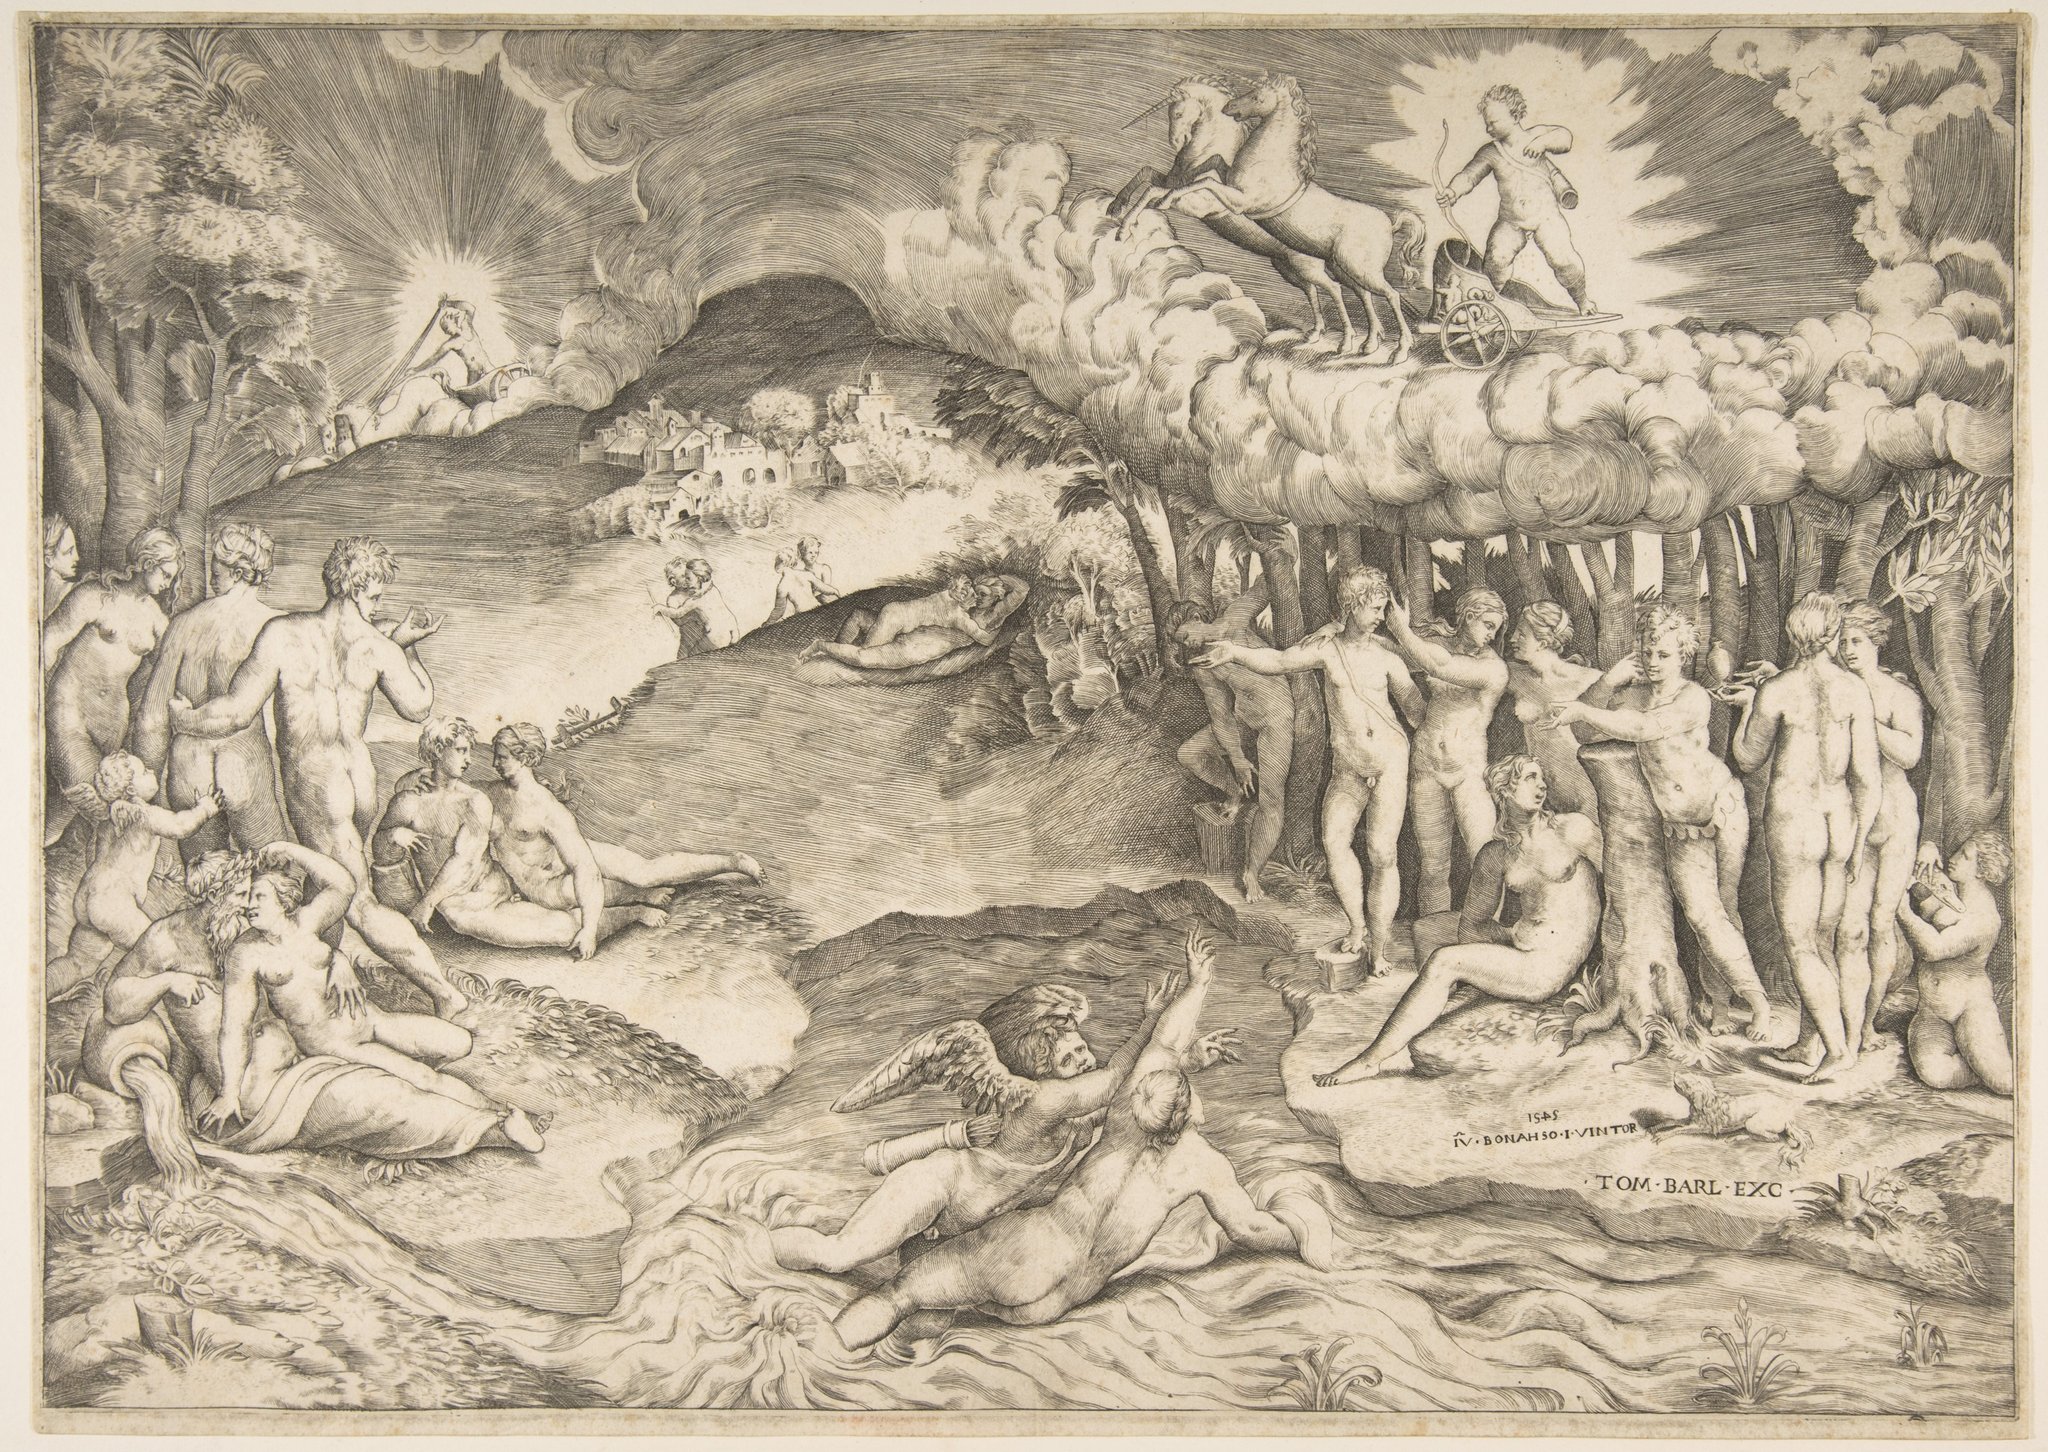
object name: print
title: The triumph of love, cupid riding a chariot drawn by unicorn is in the upper right, naked figures fill the composition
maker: giulio bonasone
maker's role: artist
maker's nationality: italian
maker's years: 1510-1576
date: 1545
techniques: engraving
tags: male nudes,female nudes,cupid,unicorns,chariots